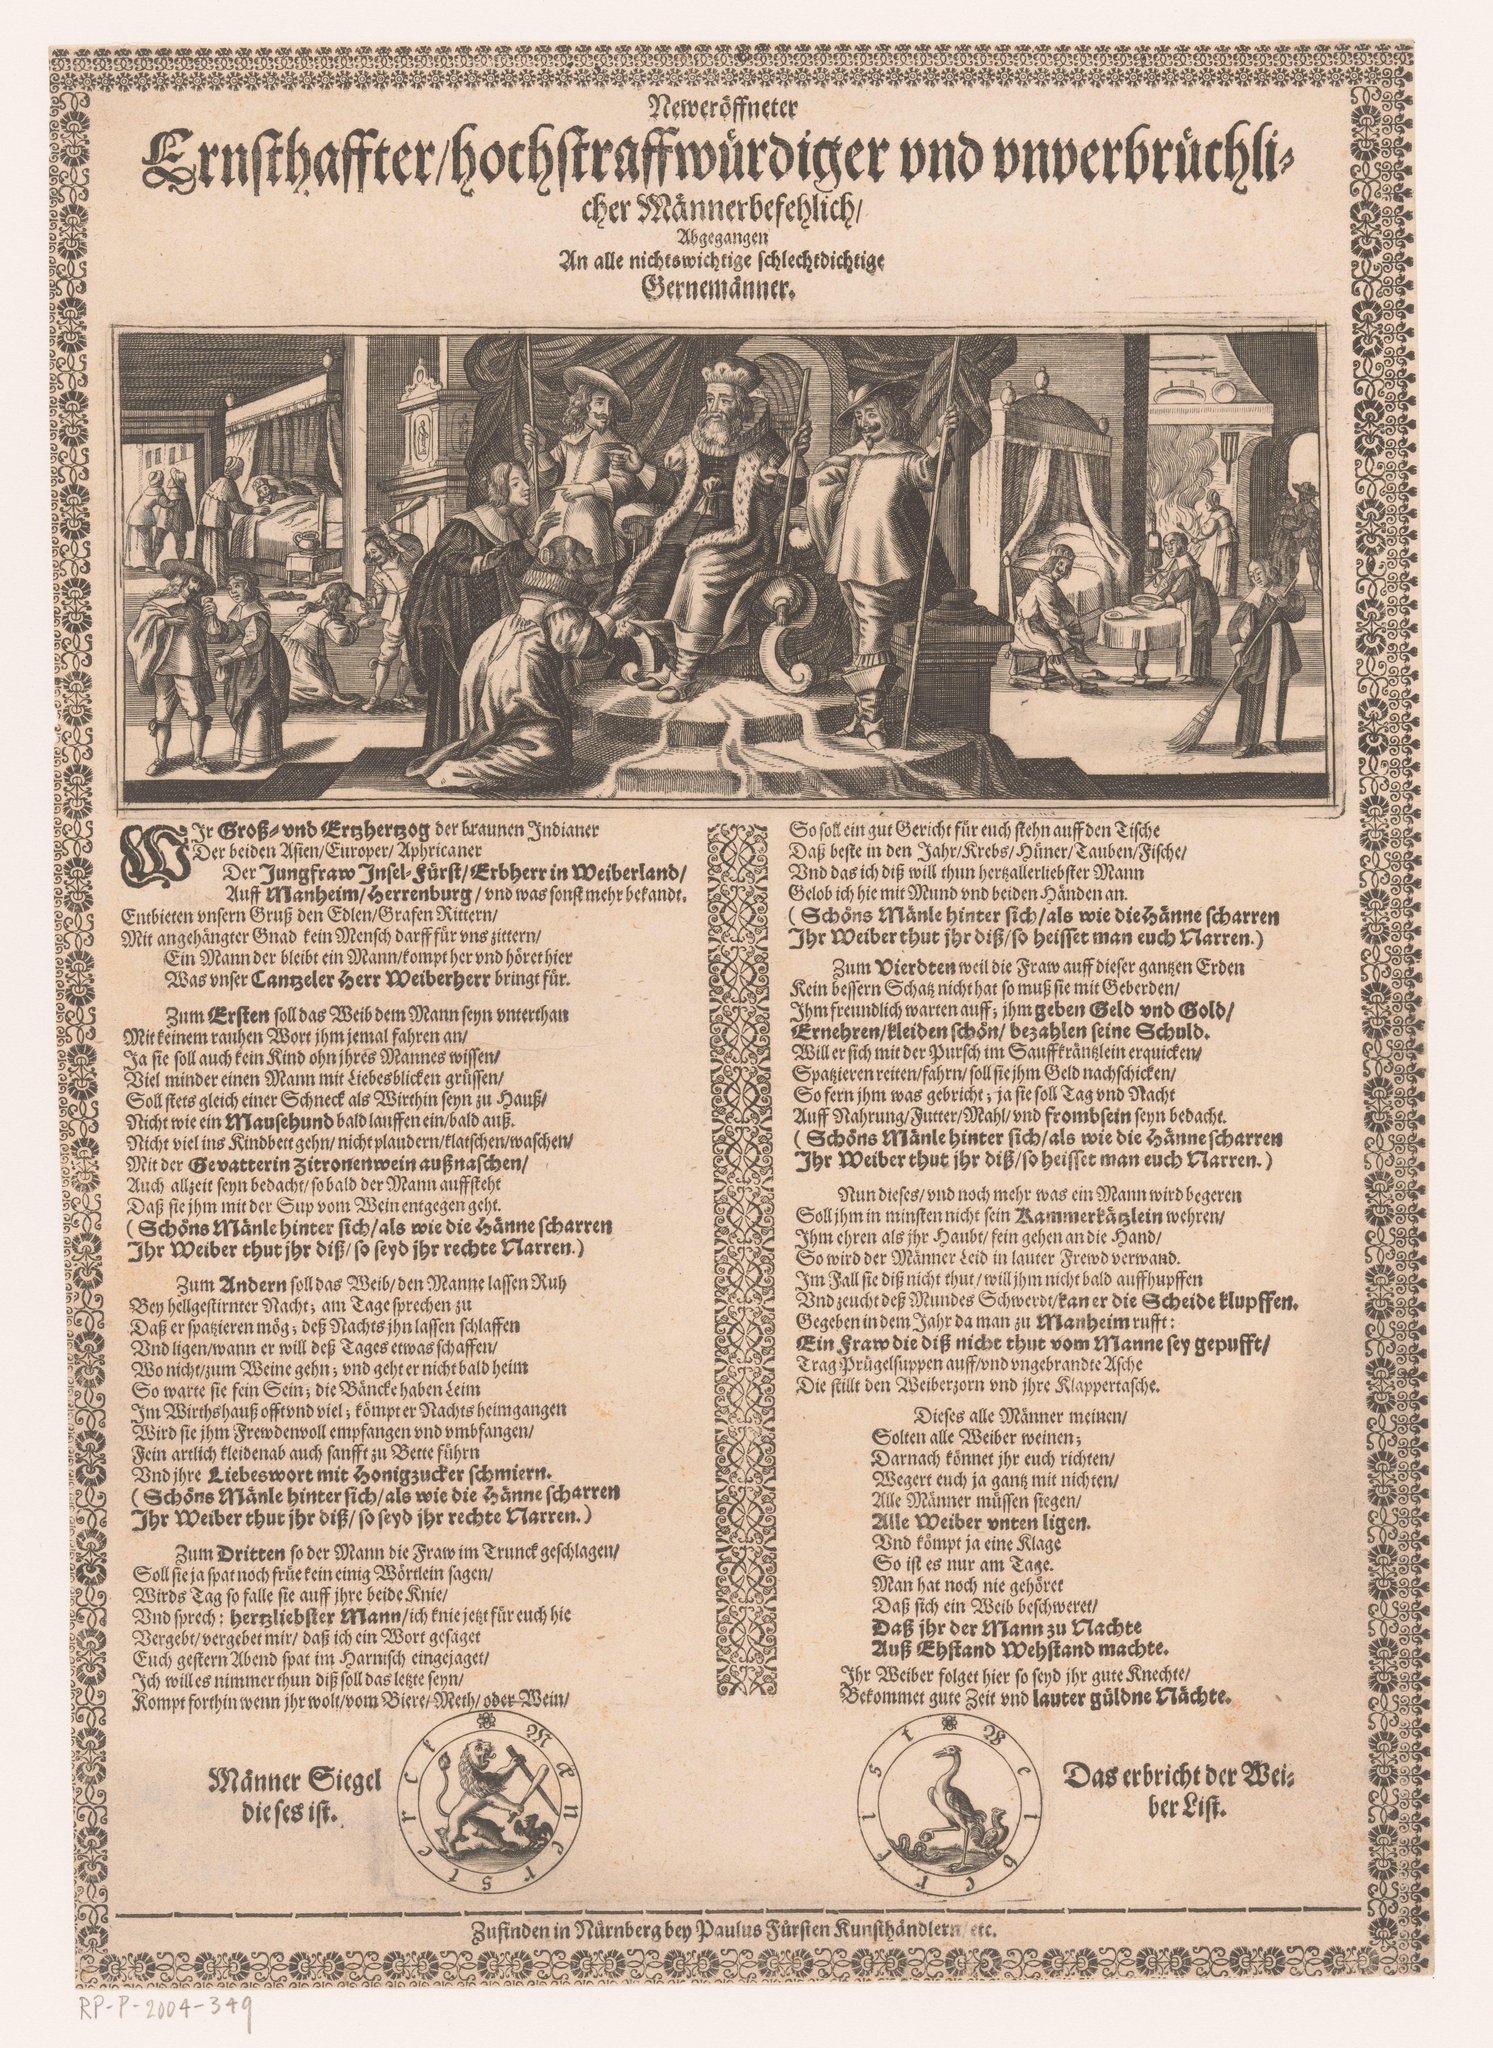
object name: pamphlet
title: Satire op de mannelijke dominantie over vrouwen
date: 1615-1666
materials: paper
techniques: engraving, letterpress printing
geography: nuremberg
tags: homage to a ruler, king, dominating husband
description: Satire op de mannelijke dominantie over vrouwen. Een koning zit op zijn troon onder baldakijn. Een vrouw geknield voor de troon. Voorstelling in ornamentrand, met twee kolommen Duitse tekst in boekdruk